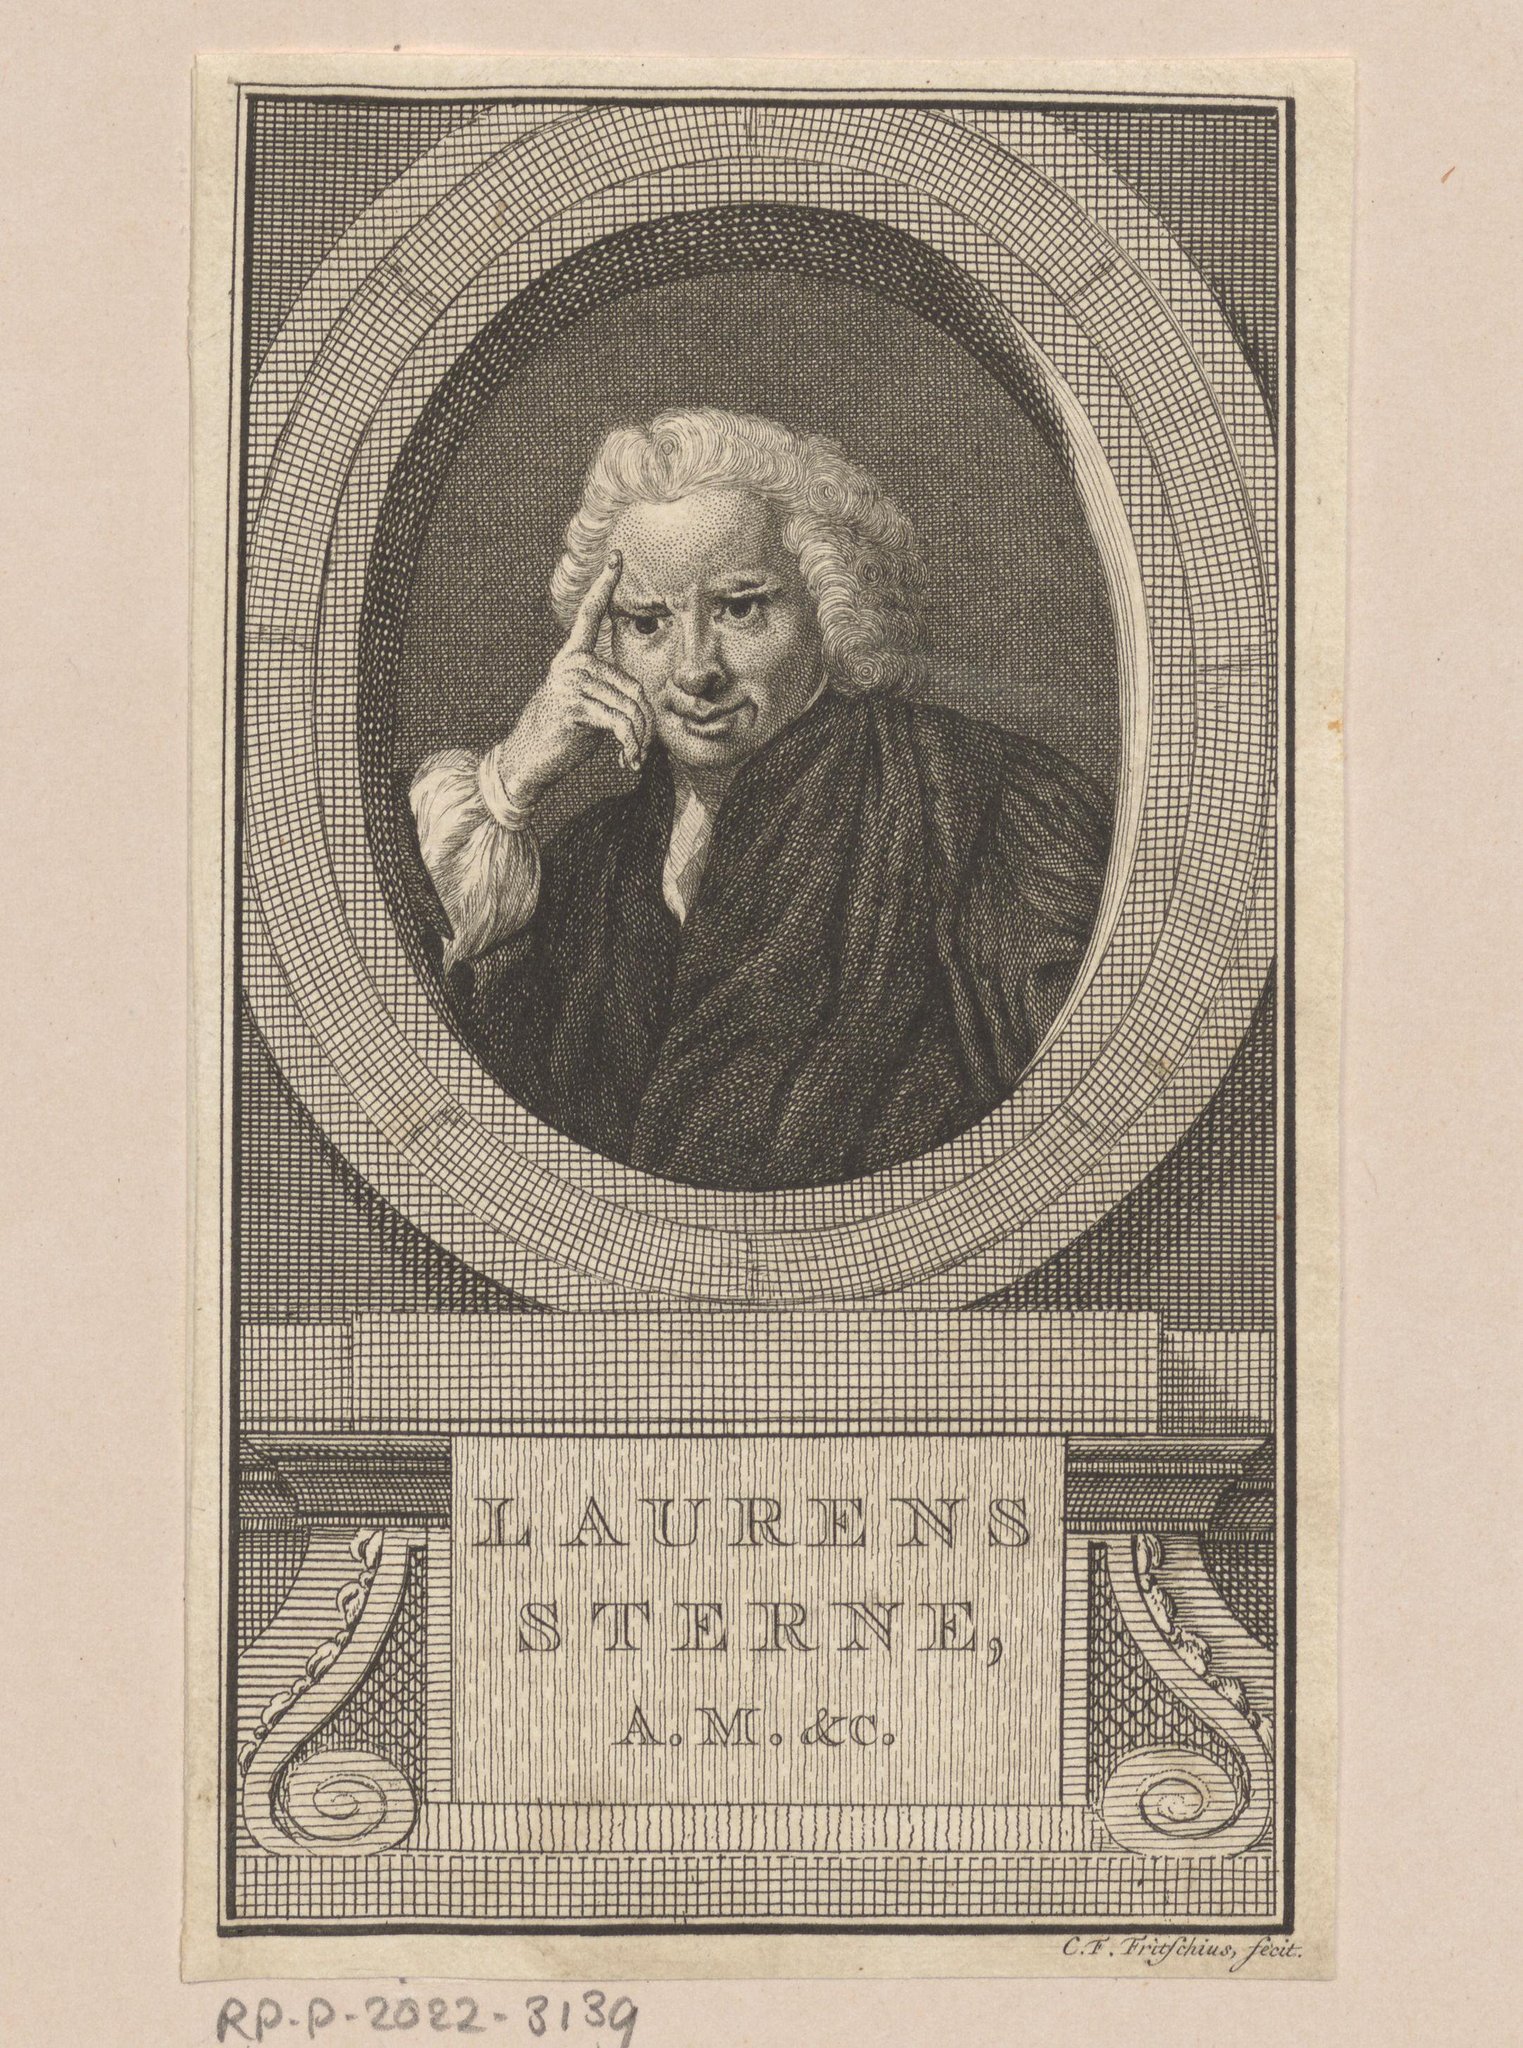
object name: print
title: Portret van Laurence Sterne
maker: christian friedrich fritzsch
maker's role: print maker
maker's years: 1719-1774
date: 1753-1774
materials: paper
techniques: etching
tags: london, clergyman, historical persons, portrait of a writer